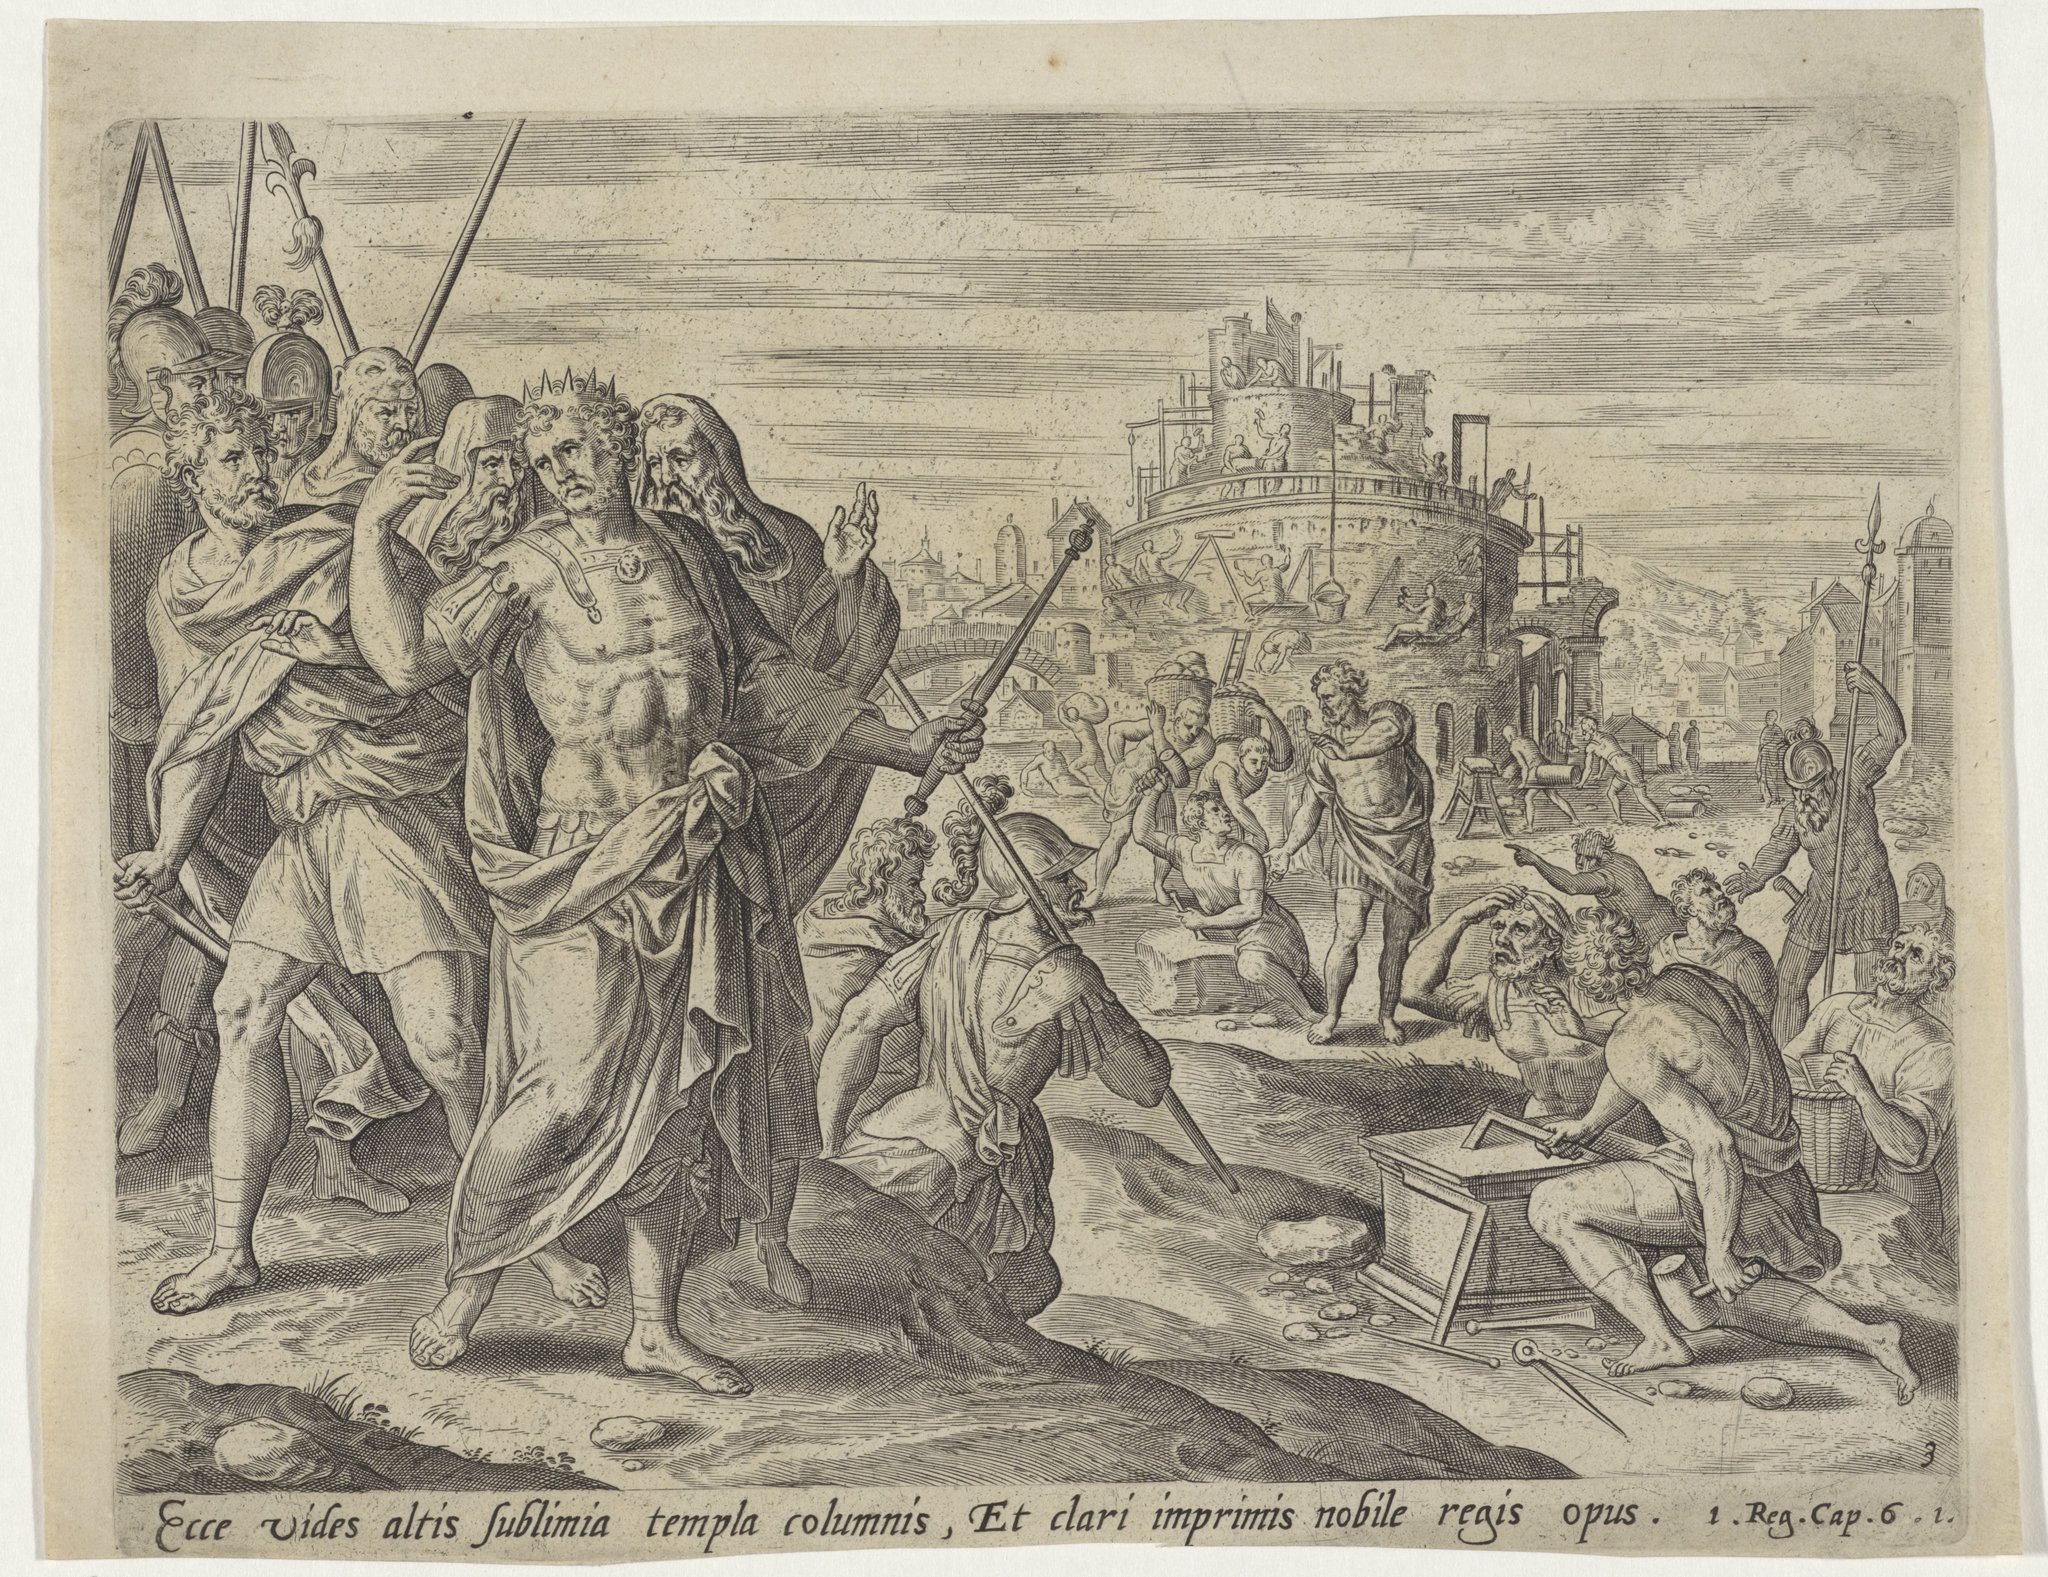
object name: print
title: Salomo laat de tempel bouwen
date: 1579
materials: paper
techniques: engraving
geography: amsterdam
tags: solomon supervising the work ~ temple of solomon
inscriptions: collector's mark: Lugt 2228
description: Prent gebruikt in: Theatrum biblicum : hoc est historiae sacrae veteris et novi testamenti tabulis aeneis expressae. Opus praesentatissimorum huius ac superioris seculi pictorum atque sculptorum, summo studio conquisitum et in lucem editum. Amsterdam: Claes Jansz. Visscher, 1643.